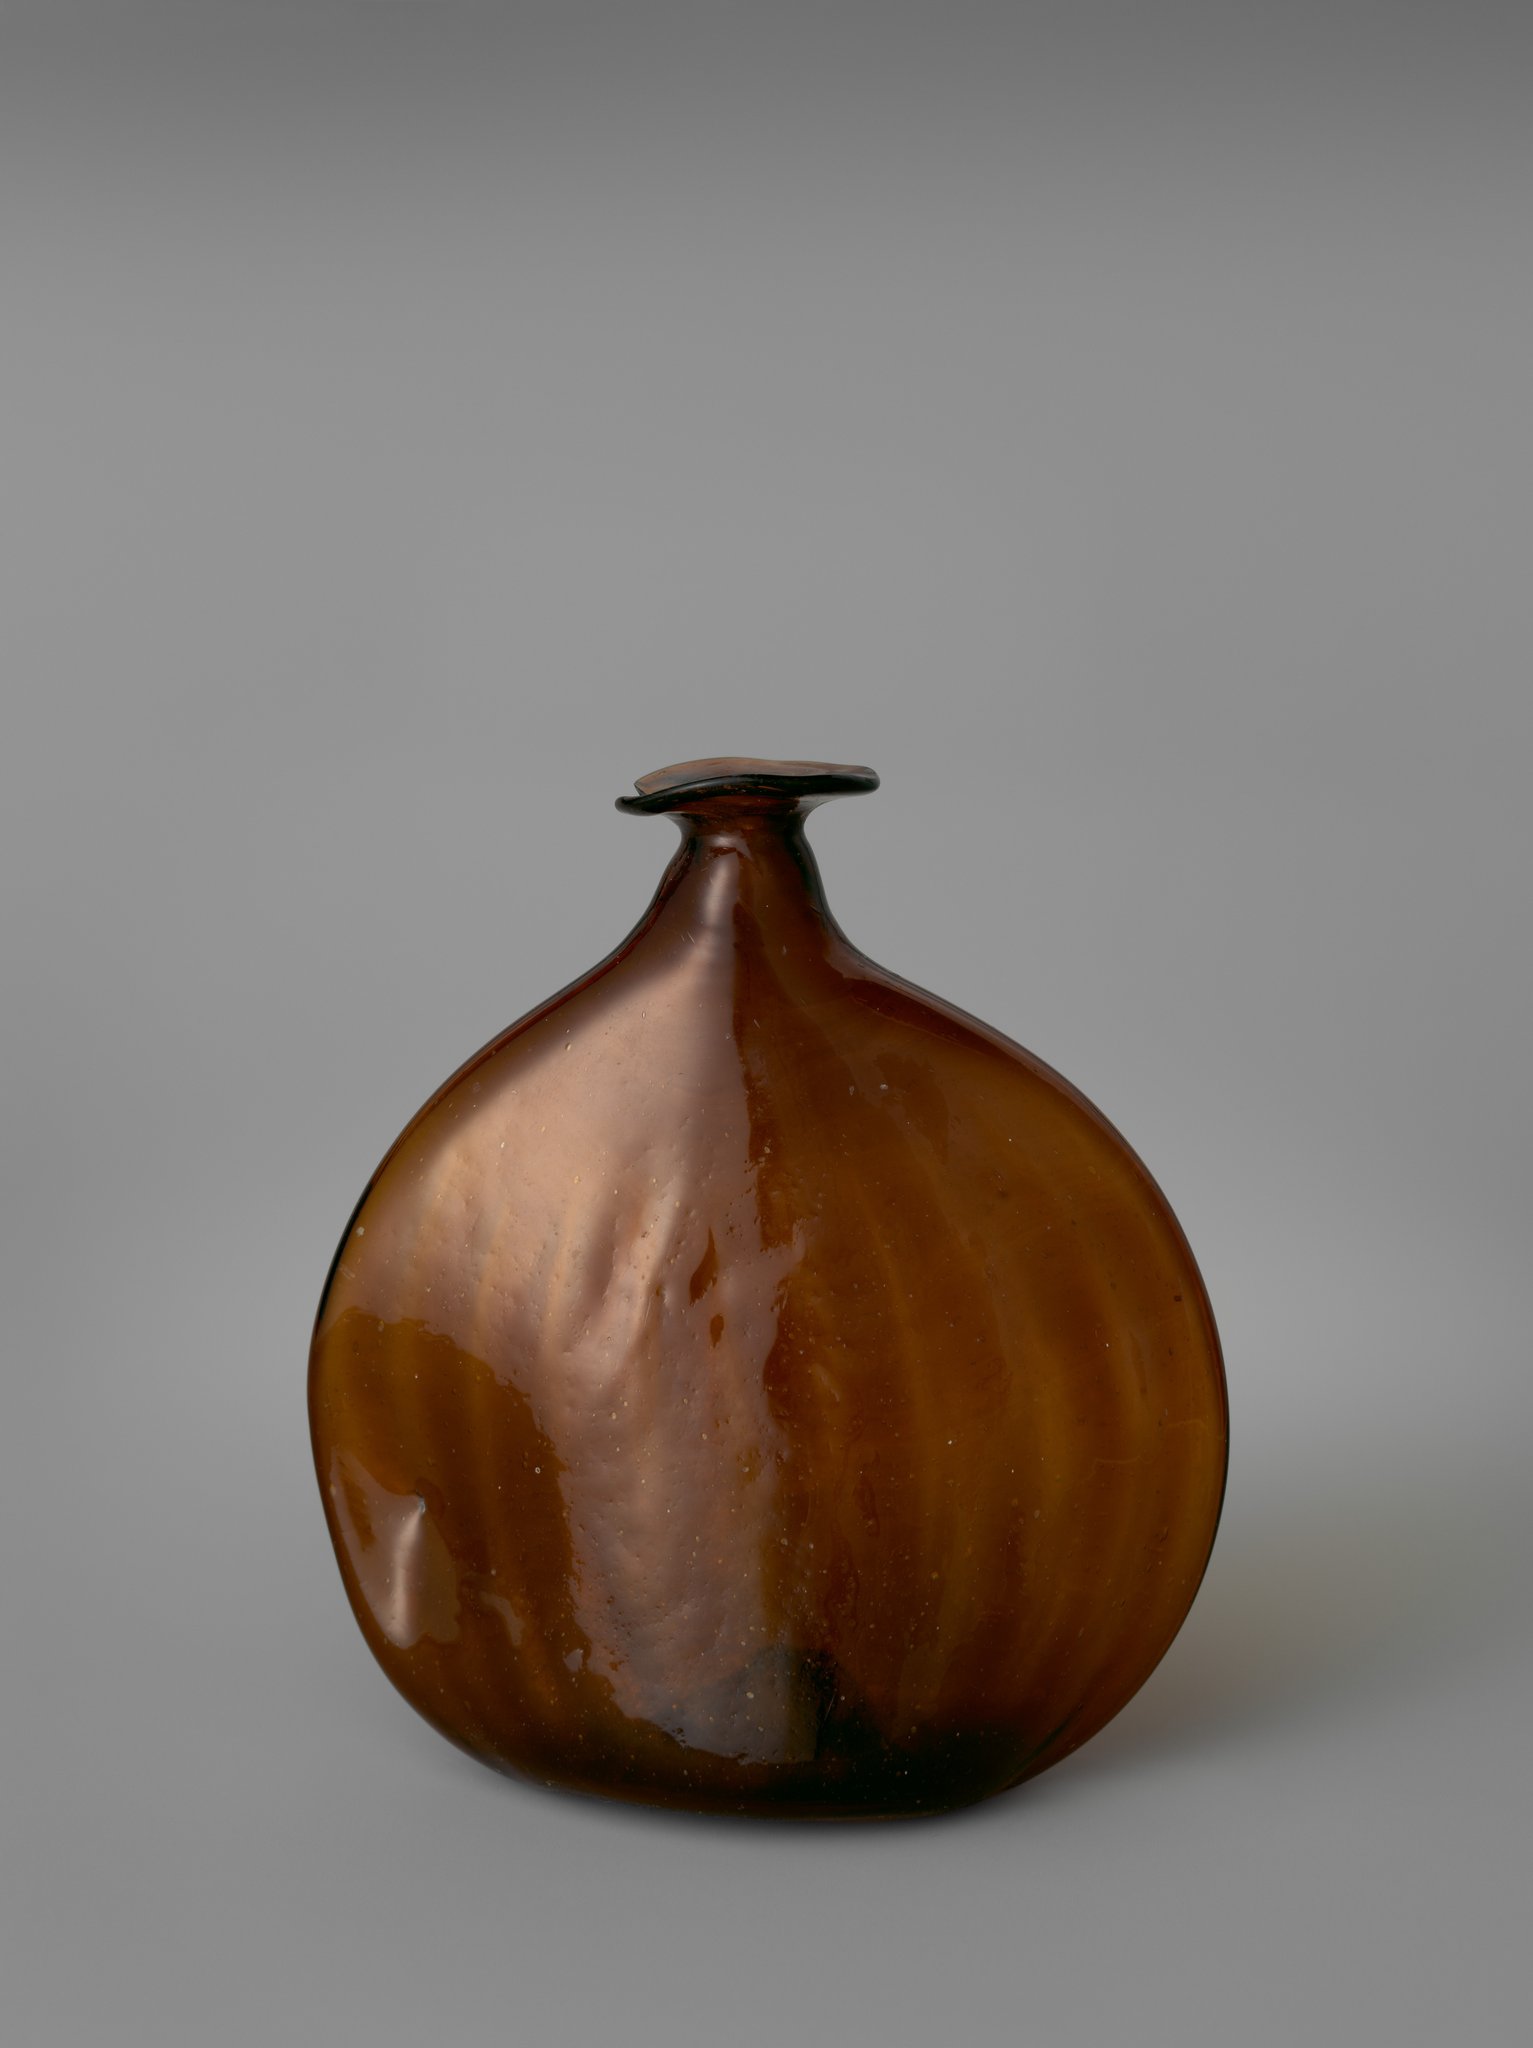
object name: flask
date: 1701-1900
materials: glass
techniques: glassblowing, tooling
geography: iran